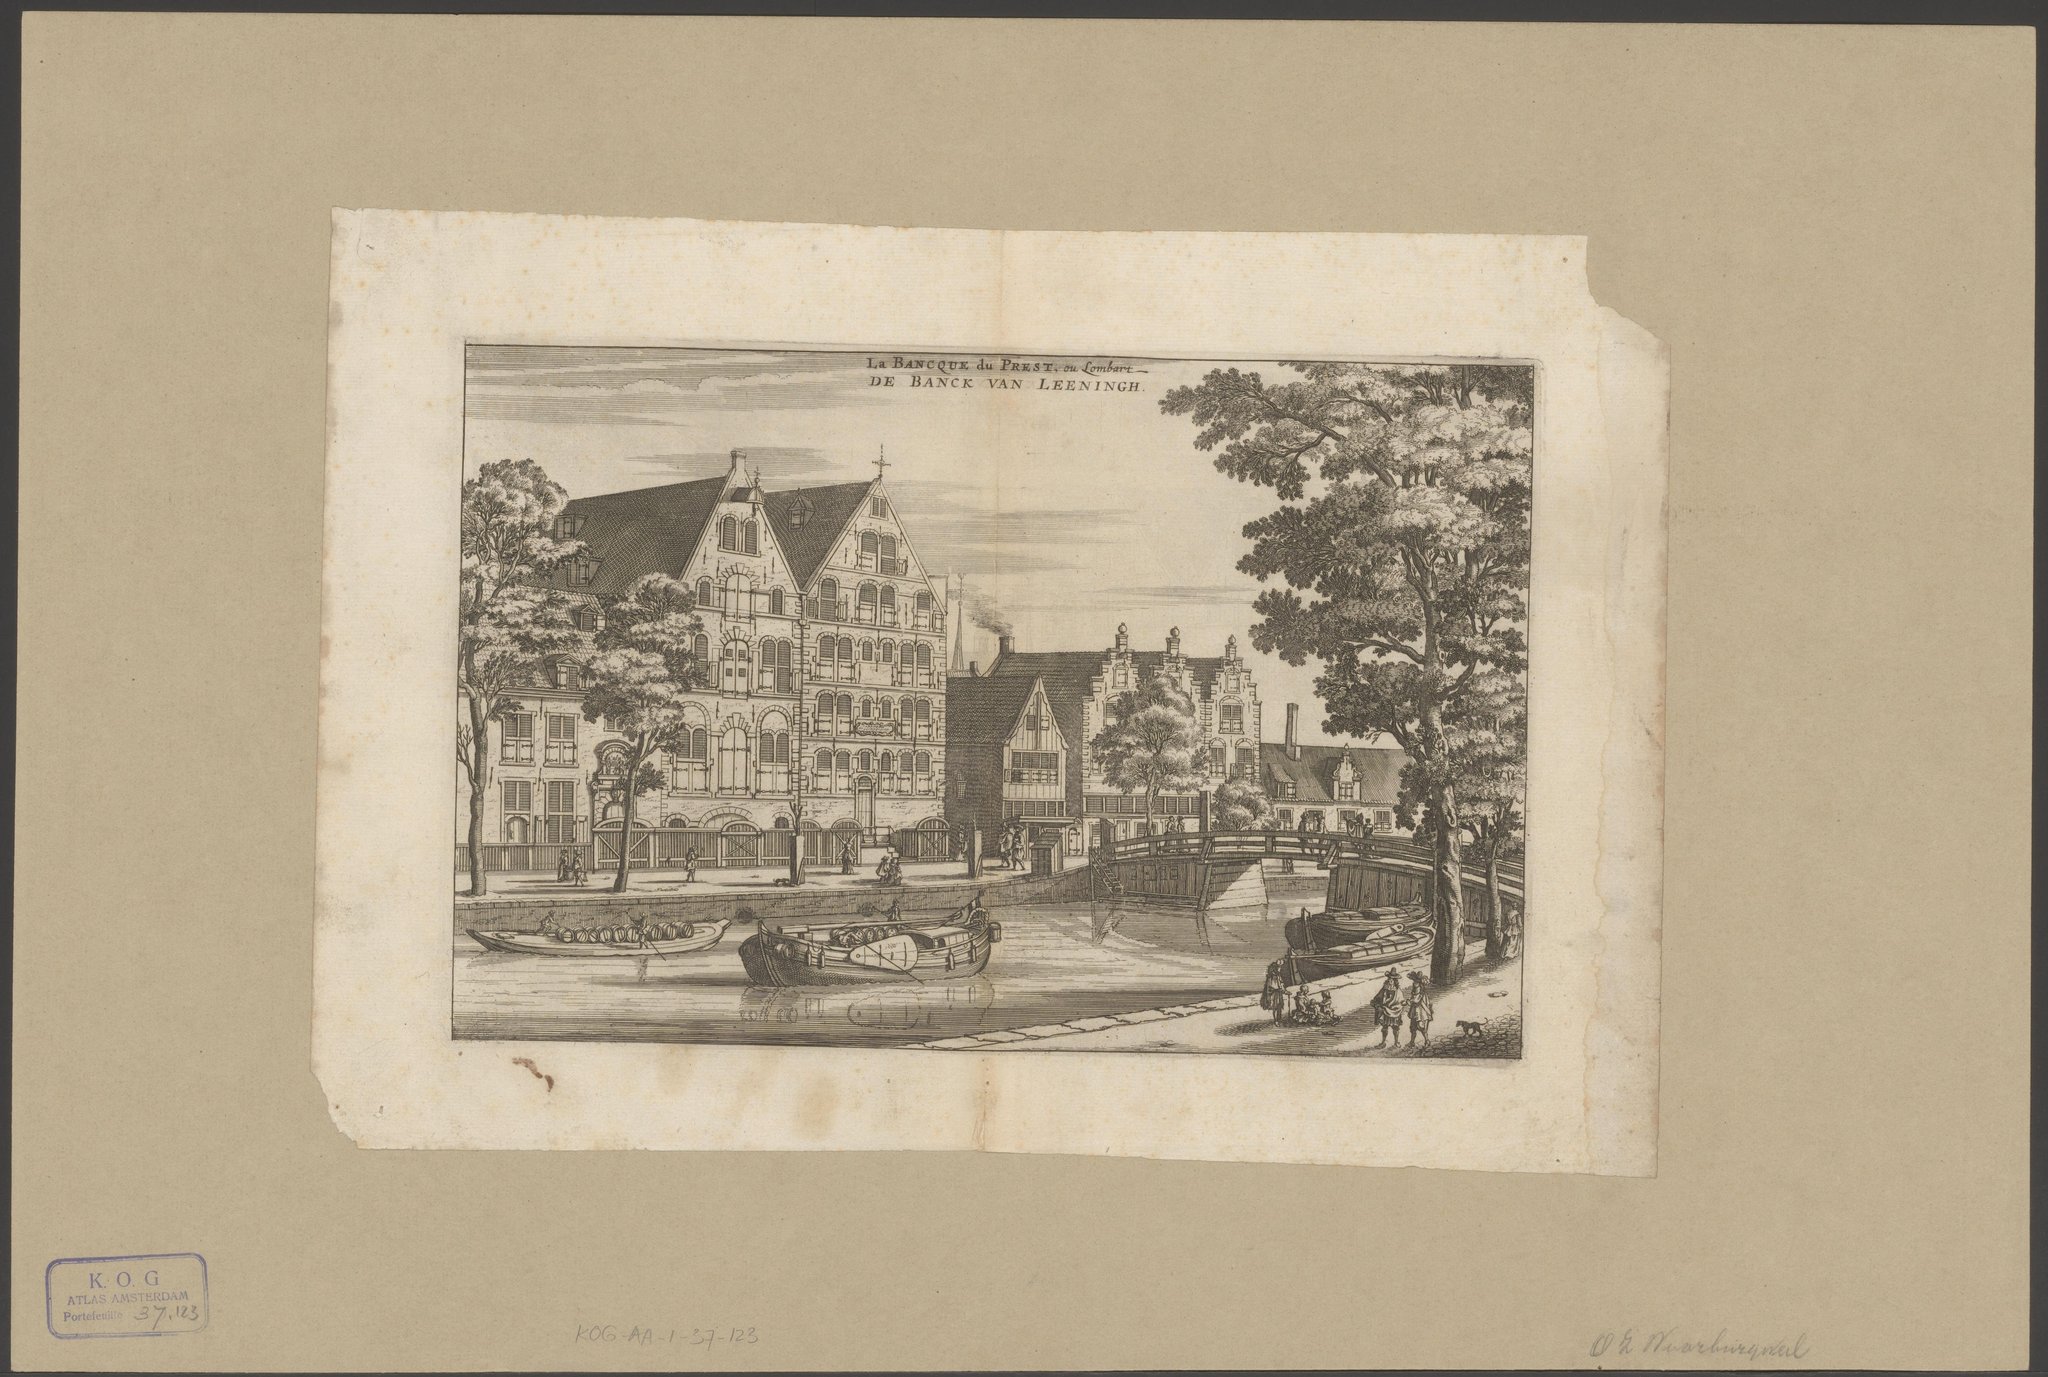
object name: print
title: La Bancque du Prest, ou Lombart / De Banck van Leeningh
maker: jacob van meurs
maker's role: draughtsman, print maker, publisher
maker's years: 1619-1680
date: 1663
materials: paper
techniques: engraving, etching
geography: amsterdam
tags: pawnbroker, lombard, bridge in city across river, canal, etc. (+ city(-scape) with figures, staffage), bank, canals, waters (in city) (+ city(-scape) with figures, staffage)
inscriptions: collector's mark: Lugt 1641b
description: Onderwerpsrubriek binnen de Atlas Amsterdam: Armwezen en liefdadige instellingen: I. Stadsinrichtingen: Lombard of Bank van Leening.